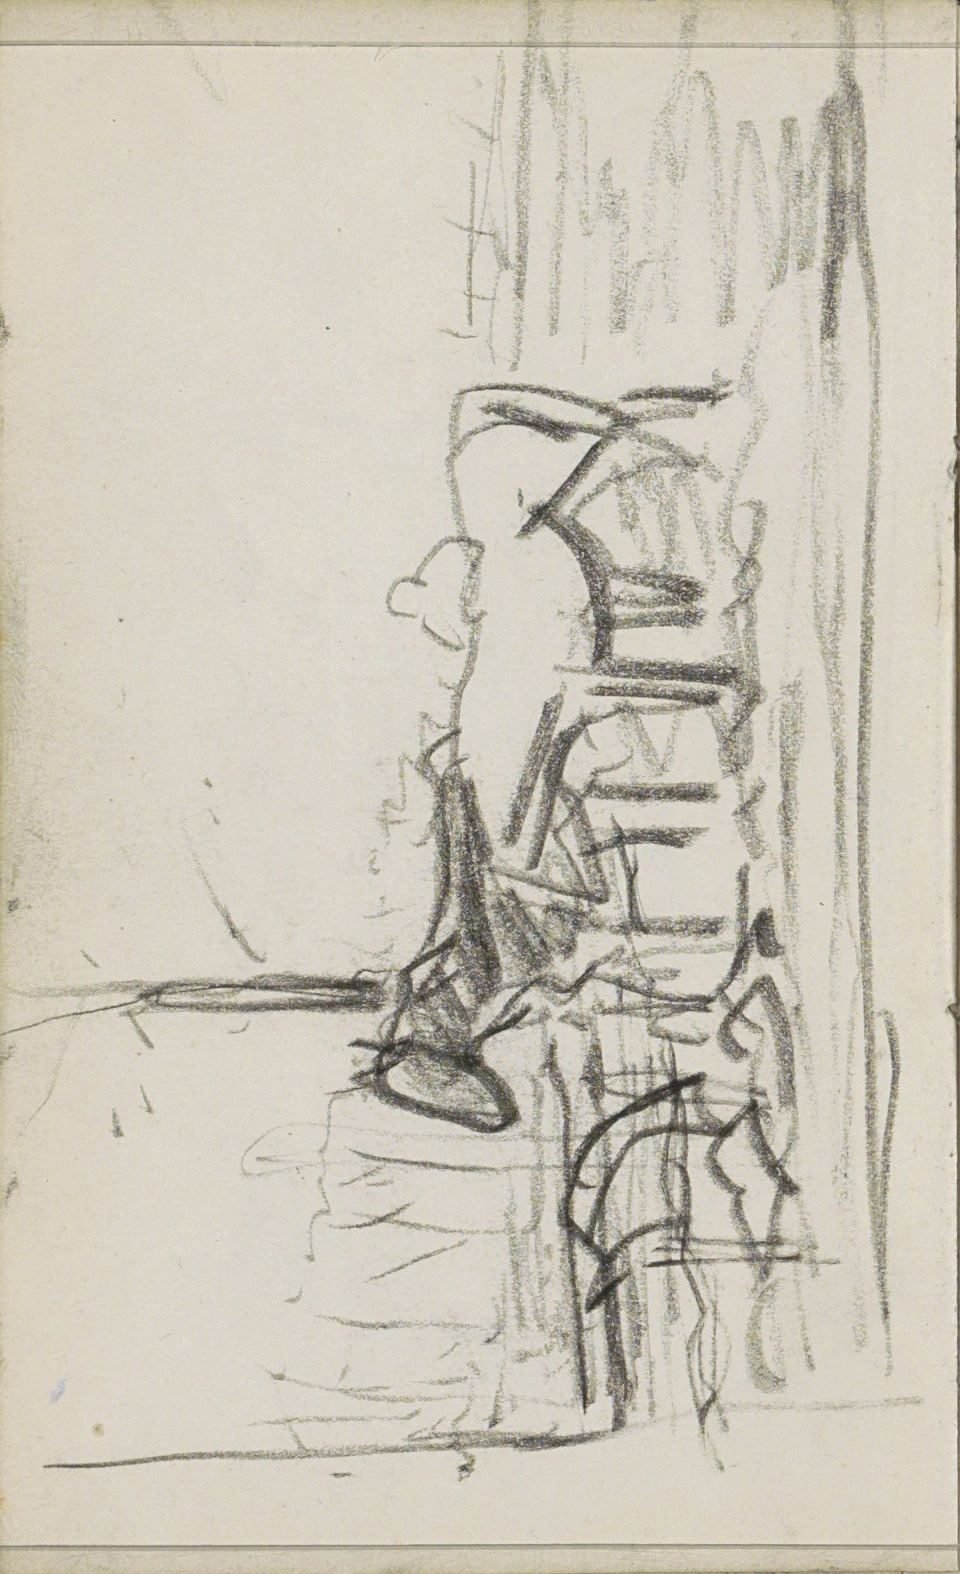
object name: sketchbook leaf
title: Weide met een figuur bij twee paarden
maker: anton mauve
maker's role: draughtsman, painter, print maker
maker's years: 1838-1888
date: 1848-1888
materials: chalk, paper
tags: horse, landscapes (+ landscape with figures, staffage)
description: Blad 30 verso uit een schetsboek met 53 bladen.